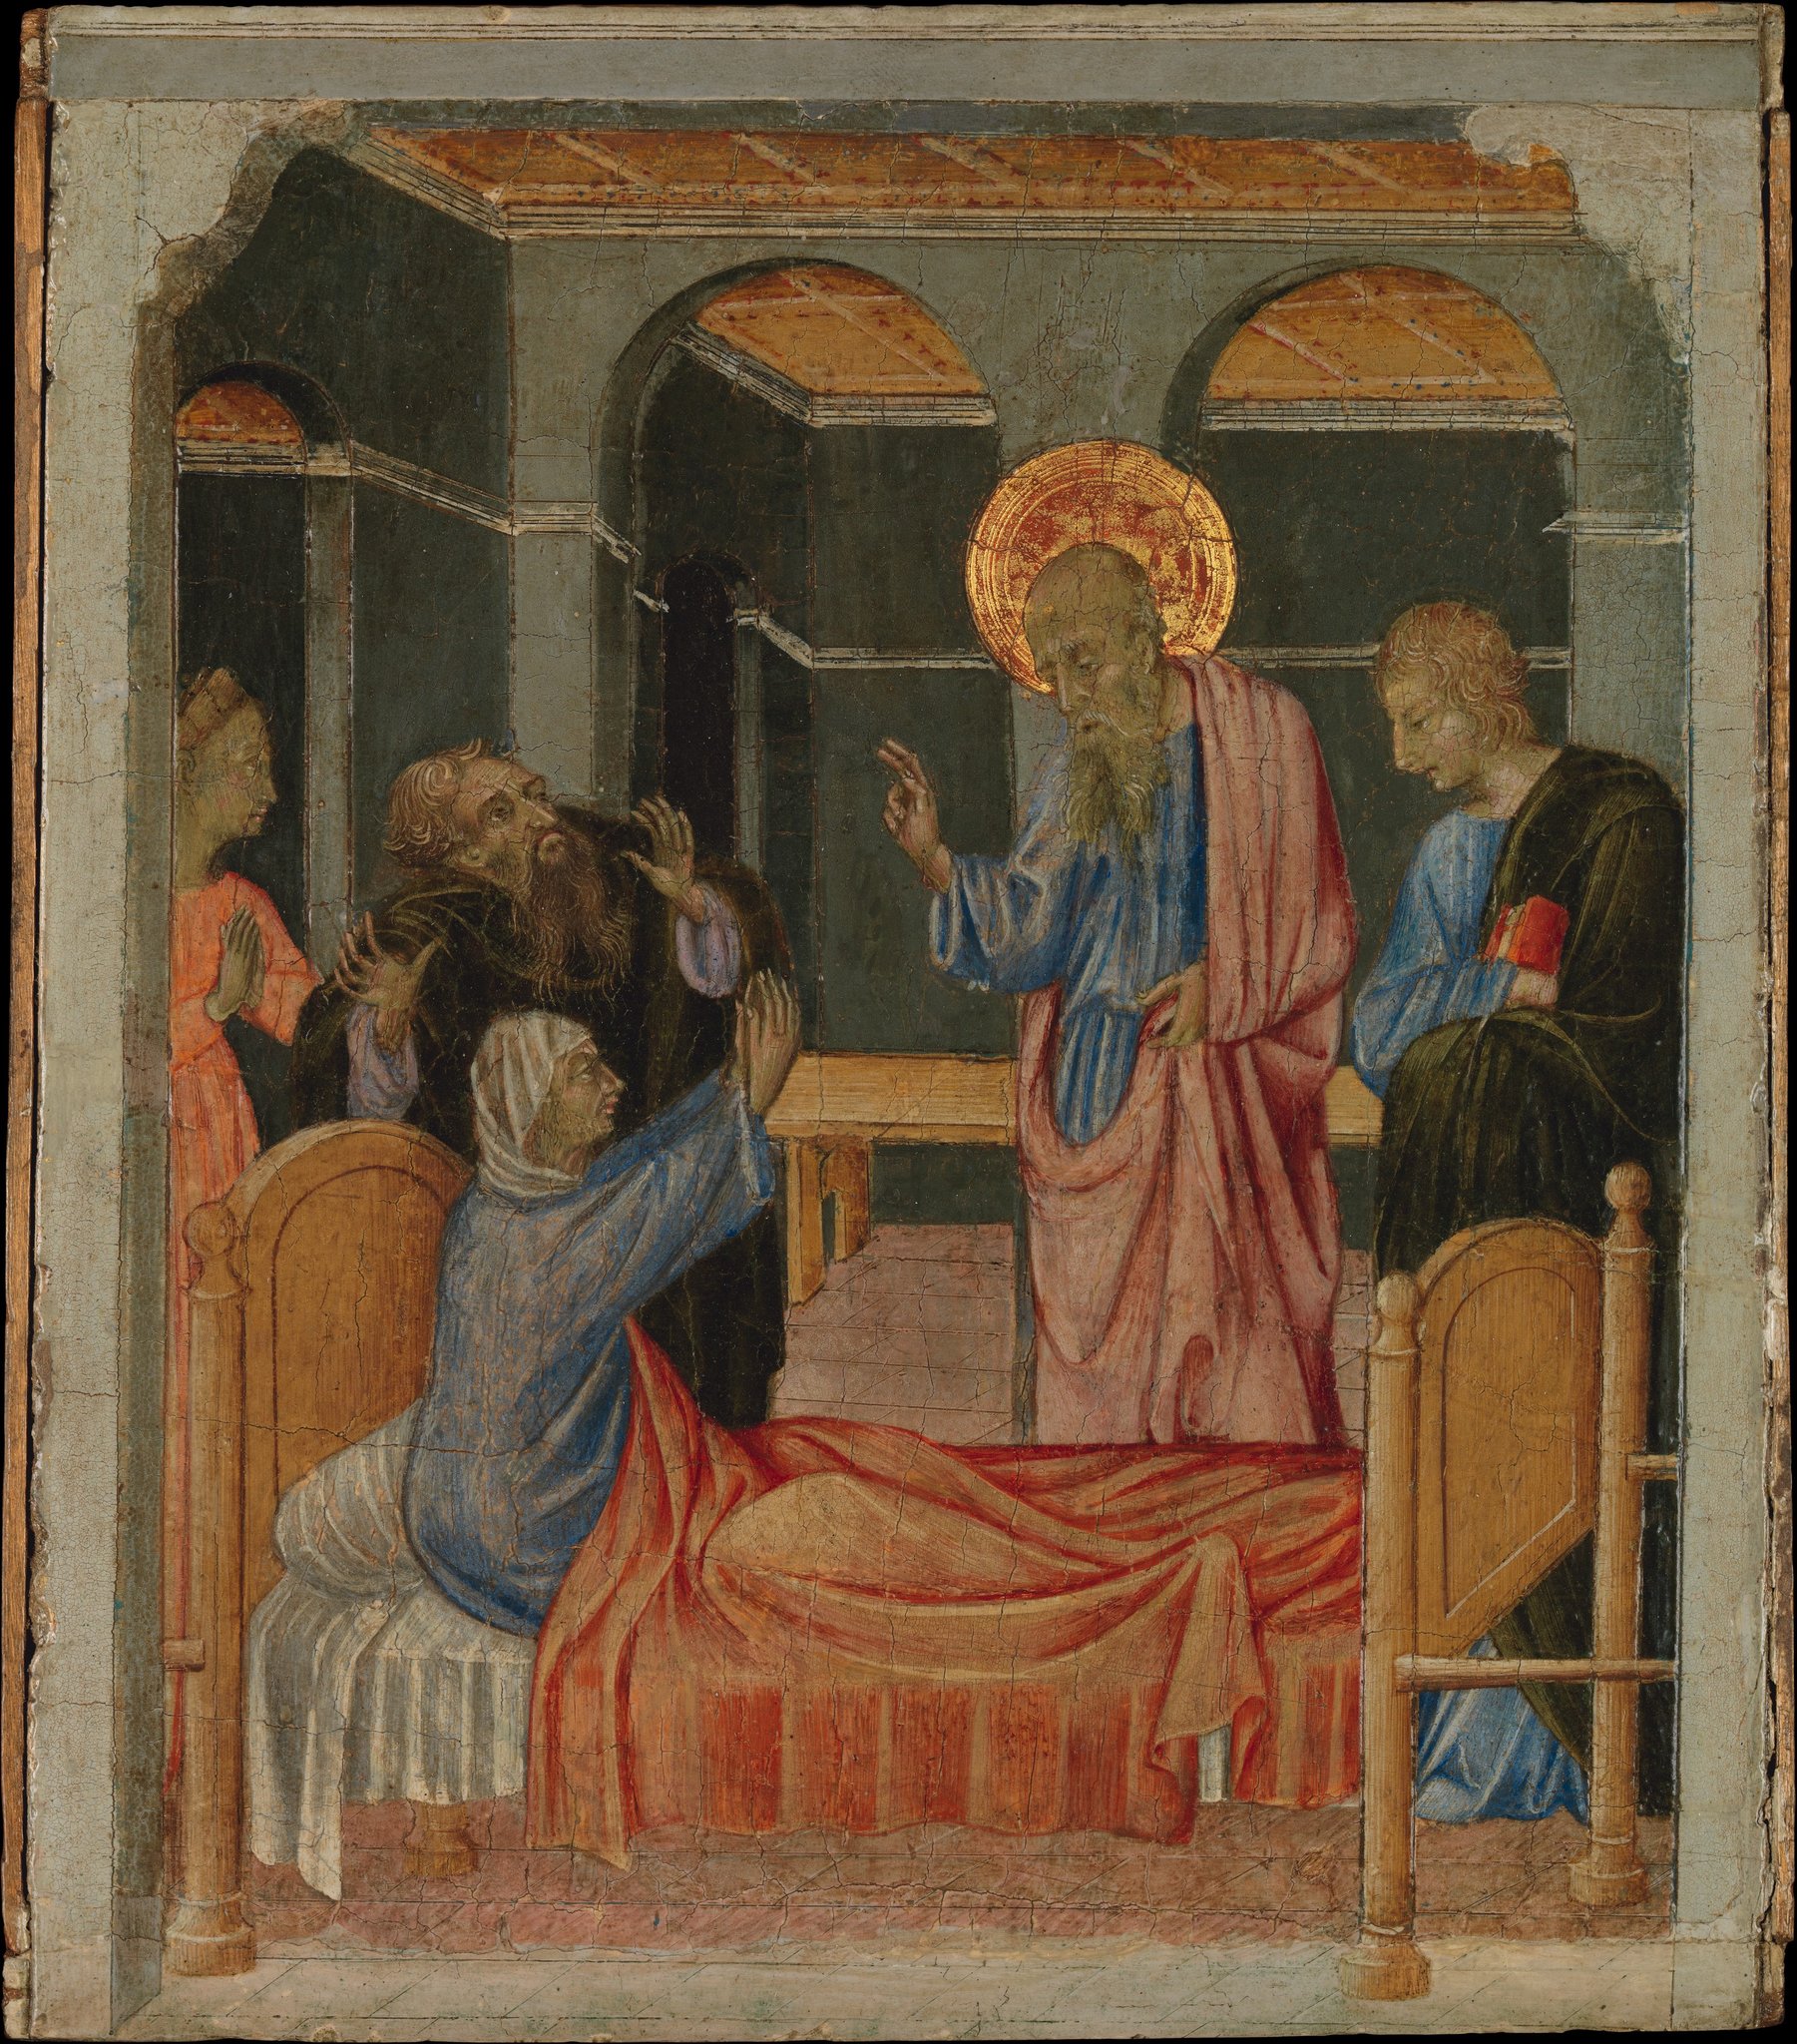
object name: painting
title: Saint John the Evangelist Raises Drusiana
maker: giovanni di paolo (giovanni di paolo di grazia)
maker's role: artist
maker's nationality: italian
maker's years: 1398-1482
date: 1460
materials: gold, paint, wood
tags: women,saint john the evangelist,beds